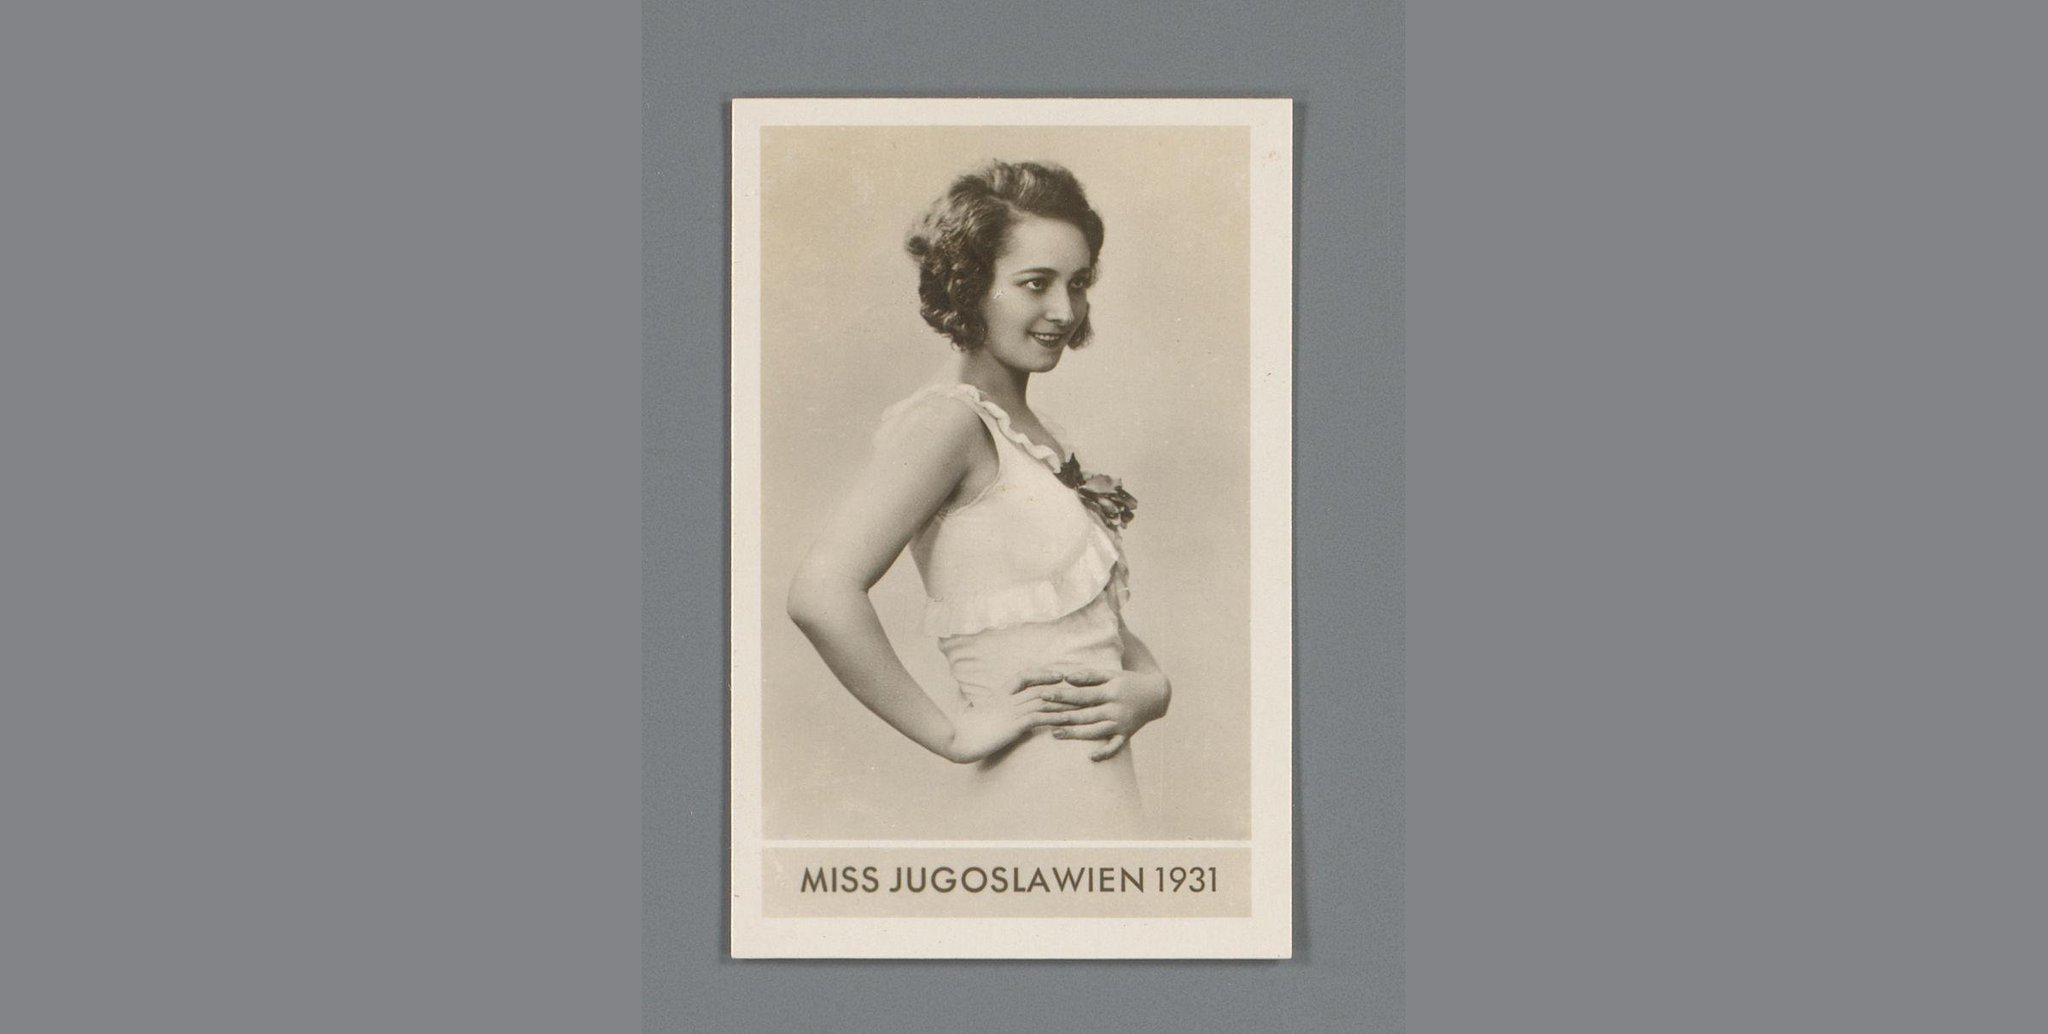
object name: photograph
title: Portret van Katica Urban, Miss Joegoslavië 1931, reclame voor Club & Liga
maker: Anonymous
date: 1931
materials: paper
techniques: gelatin silver print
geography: dresden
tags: historical persons - bb - woman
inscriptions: inscription: ‘Die schönsten/ Frauen der Welt/ dargestellt durch die Schön-/ heitsköniginnen aller Länder,/ finden Sie in 190 echten/ Bromsilber-Fotos, die nur den/ CLUB-und-LIGA-Packun-/ gen beiliegen. Eind prächtiges/ Sammel-Album erhalten Sie/ für 75 Pfennig vom Händler/ oder bei Einsendung von/ 75 Pfennig in Briefmarken/ von der Bilderstelle Lohse,/ Dresden A24, Nossener Str. 1./ Ges. gesch. Nachdruck verboten!’